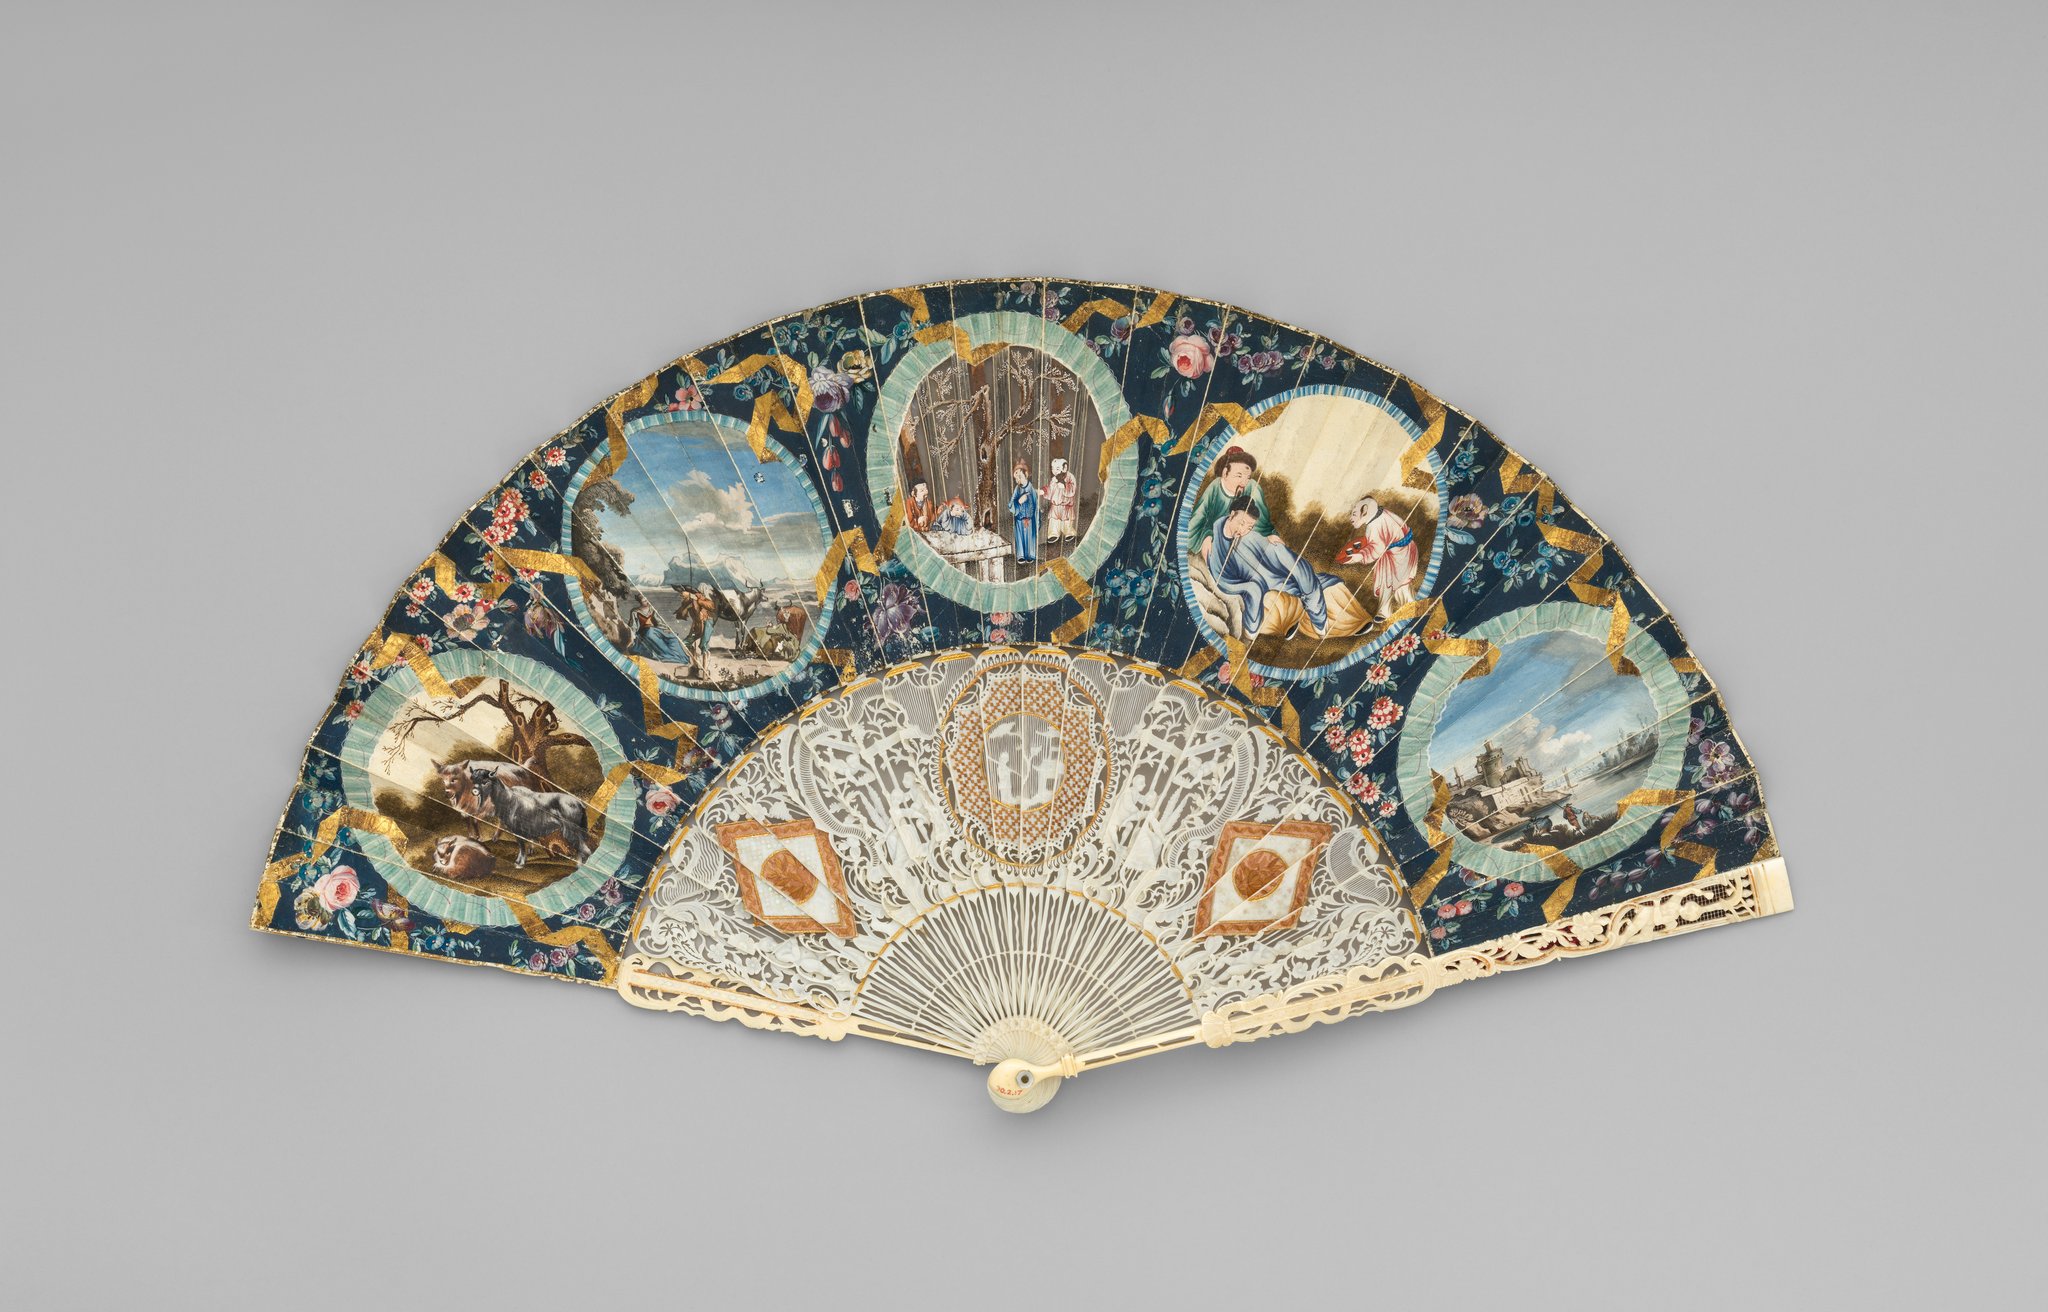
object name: fan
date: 1734-1766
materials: gold, ivory, mica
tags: men,cows